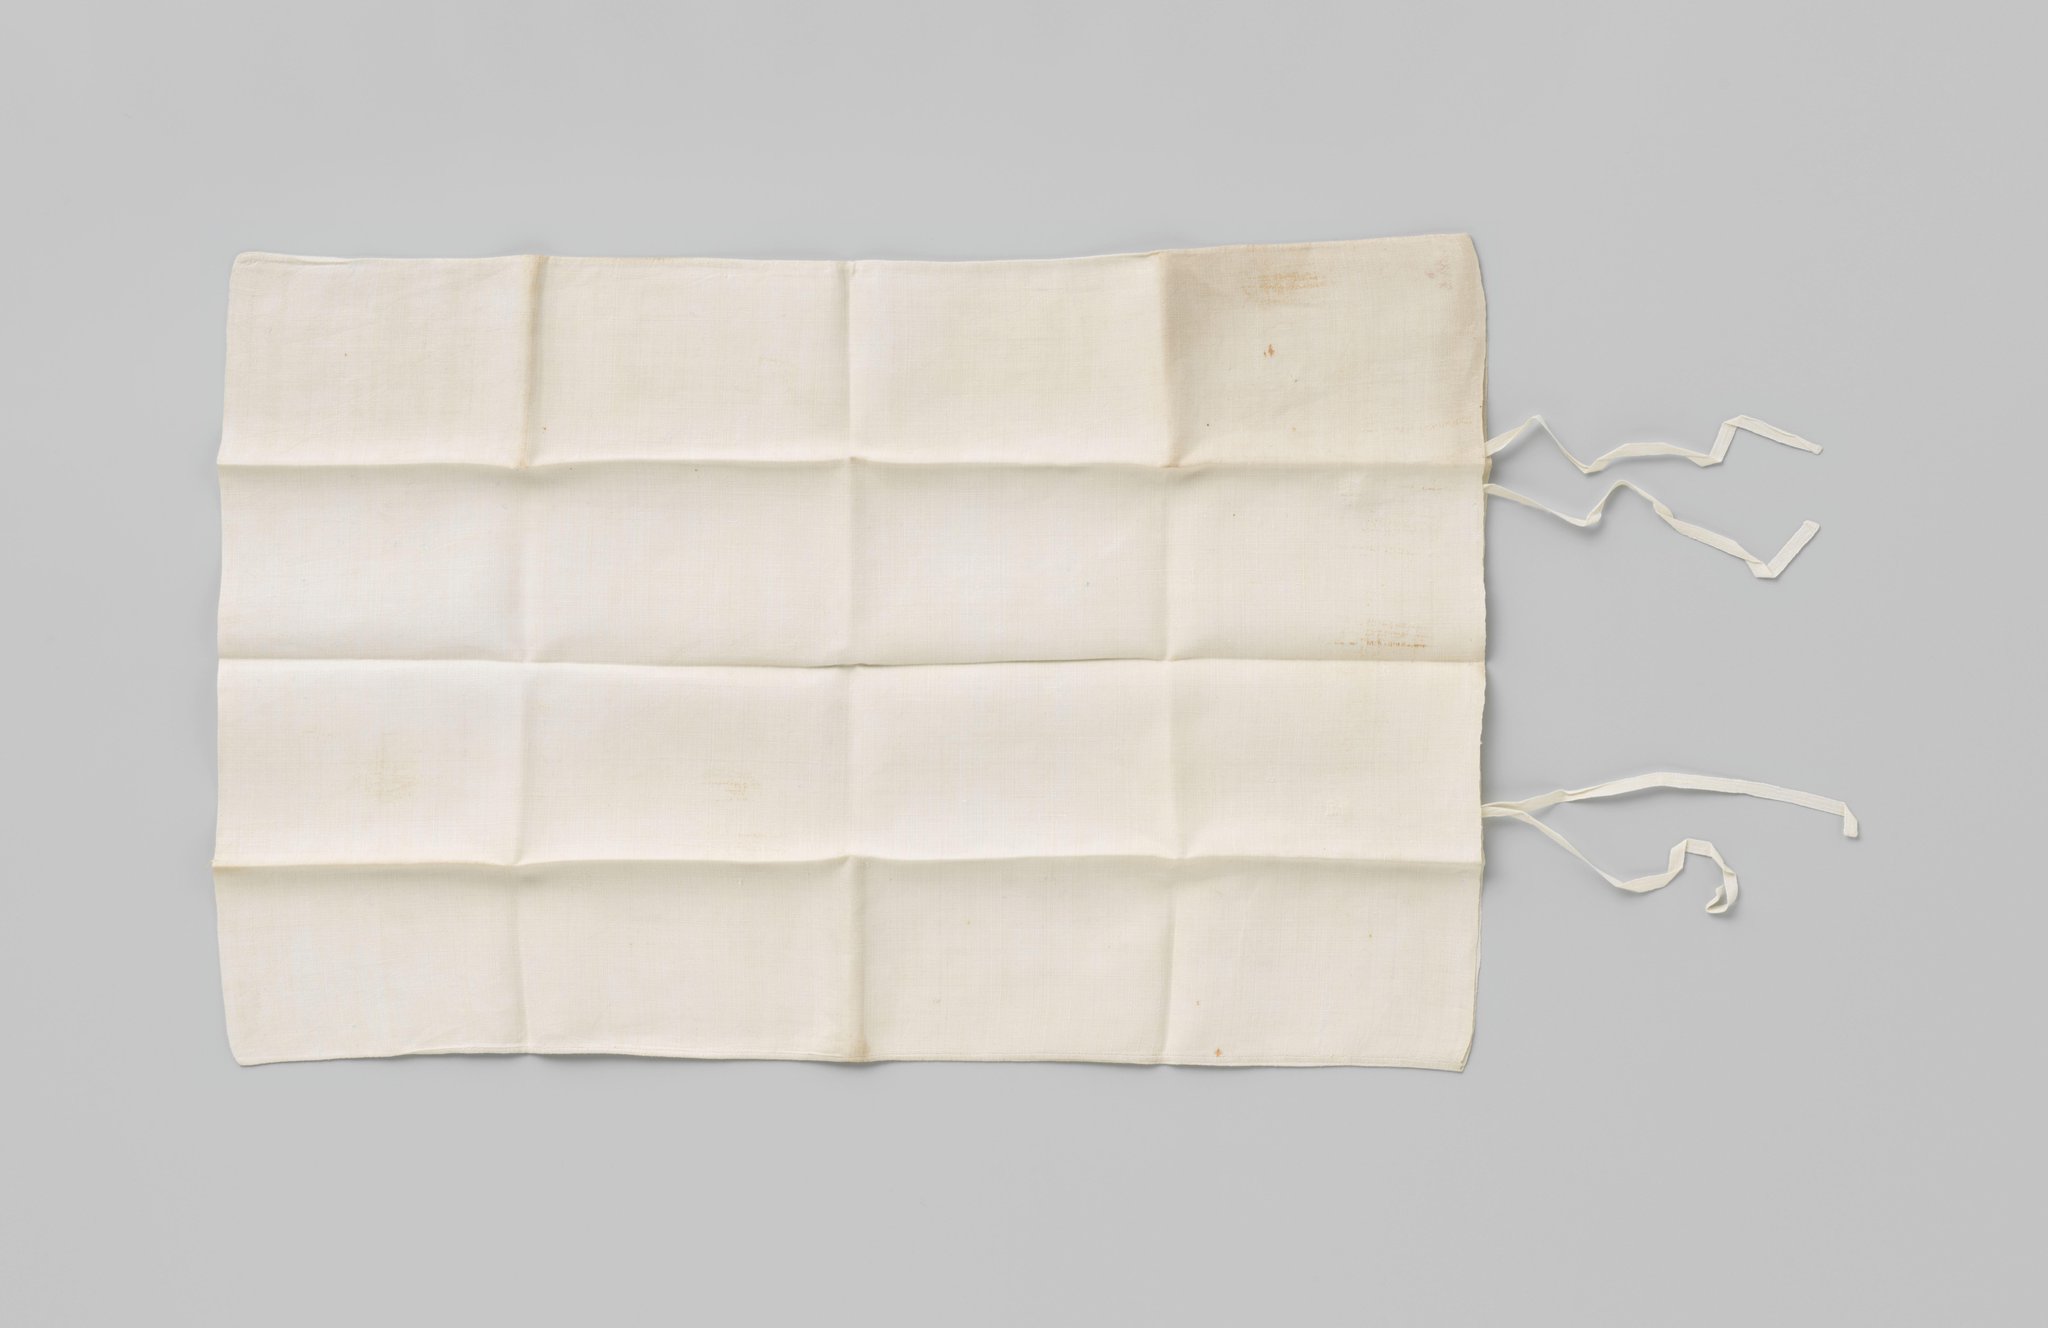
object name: sloop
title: Sloop of lendesloop, merk: WT 9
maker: Anonymous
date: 1750-1799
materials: linen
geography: northern netherlands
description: Sloop of lendesloop van wit linnen, merk WT 9.